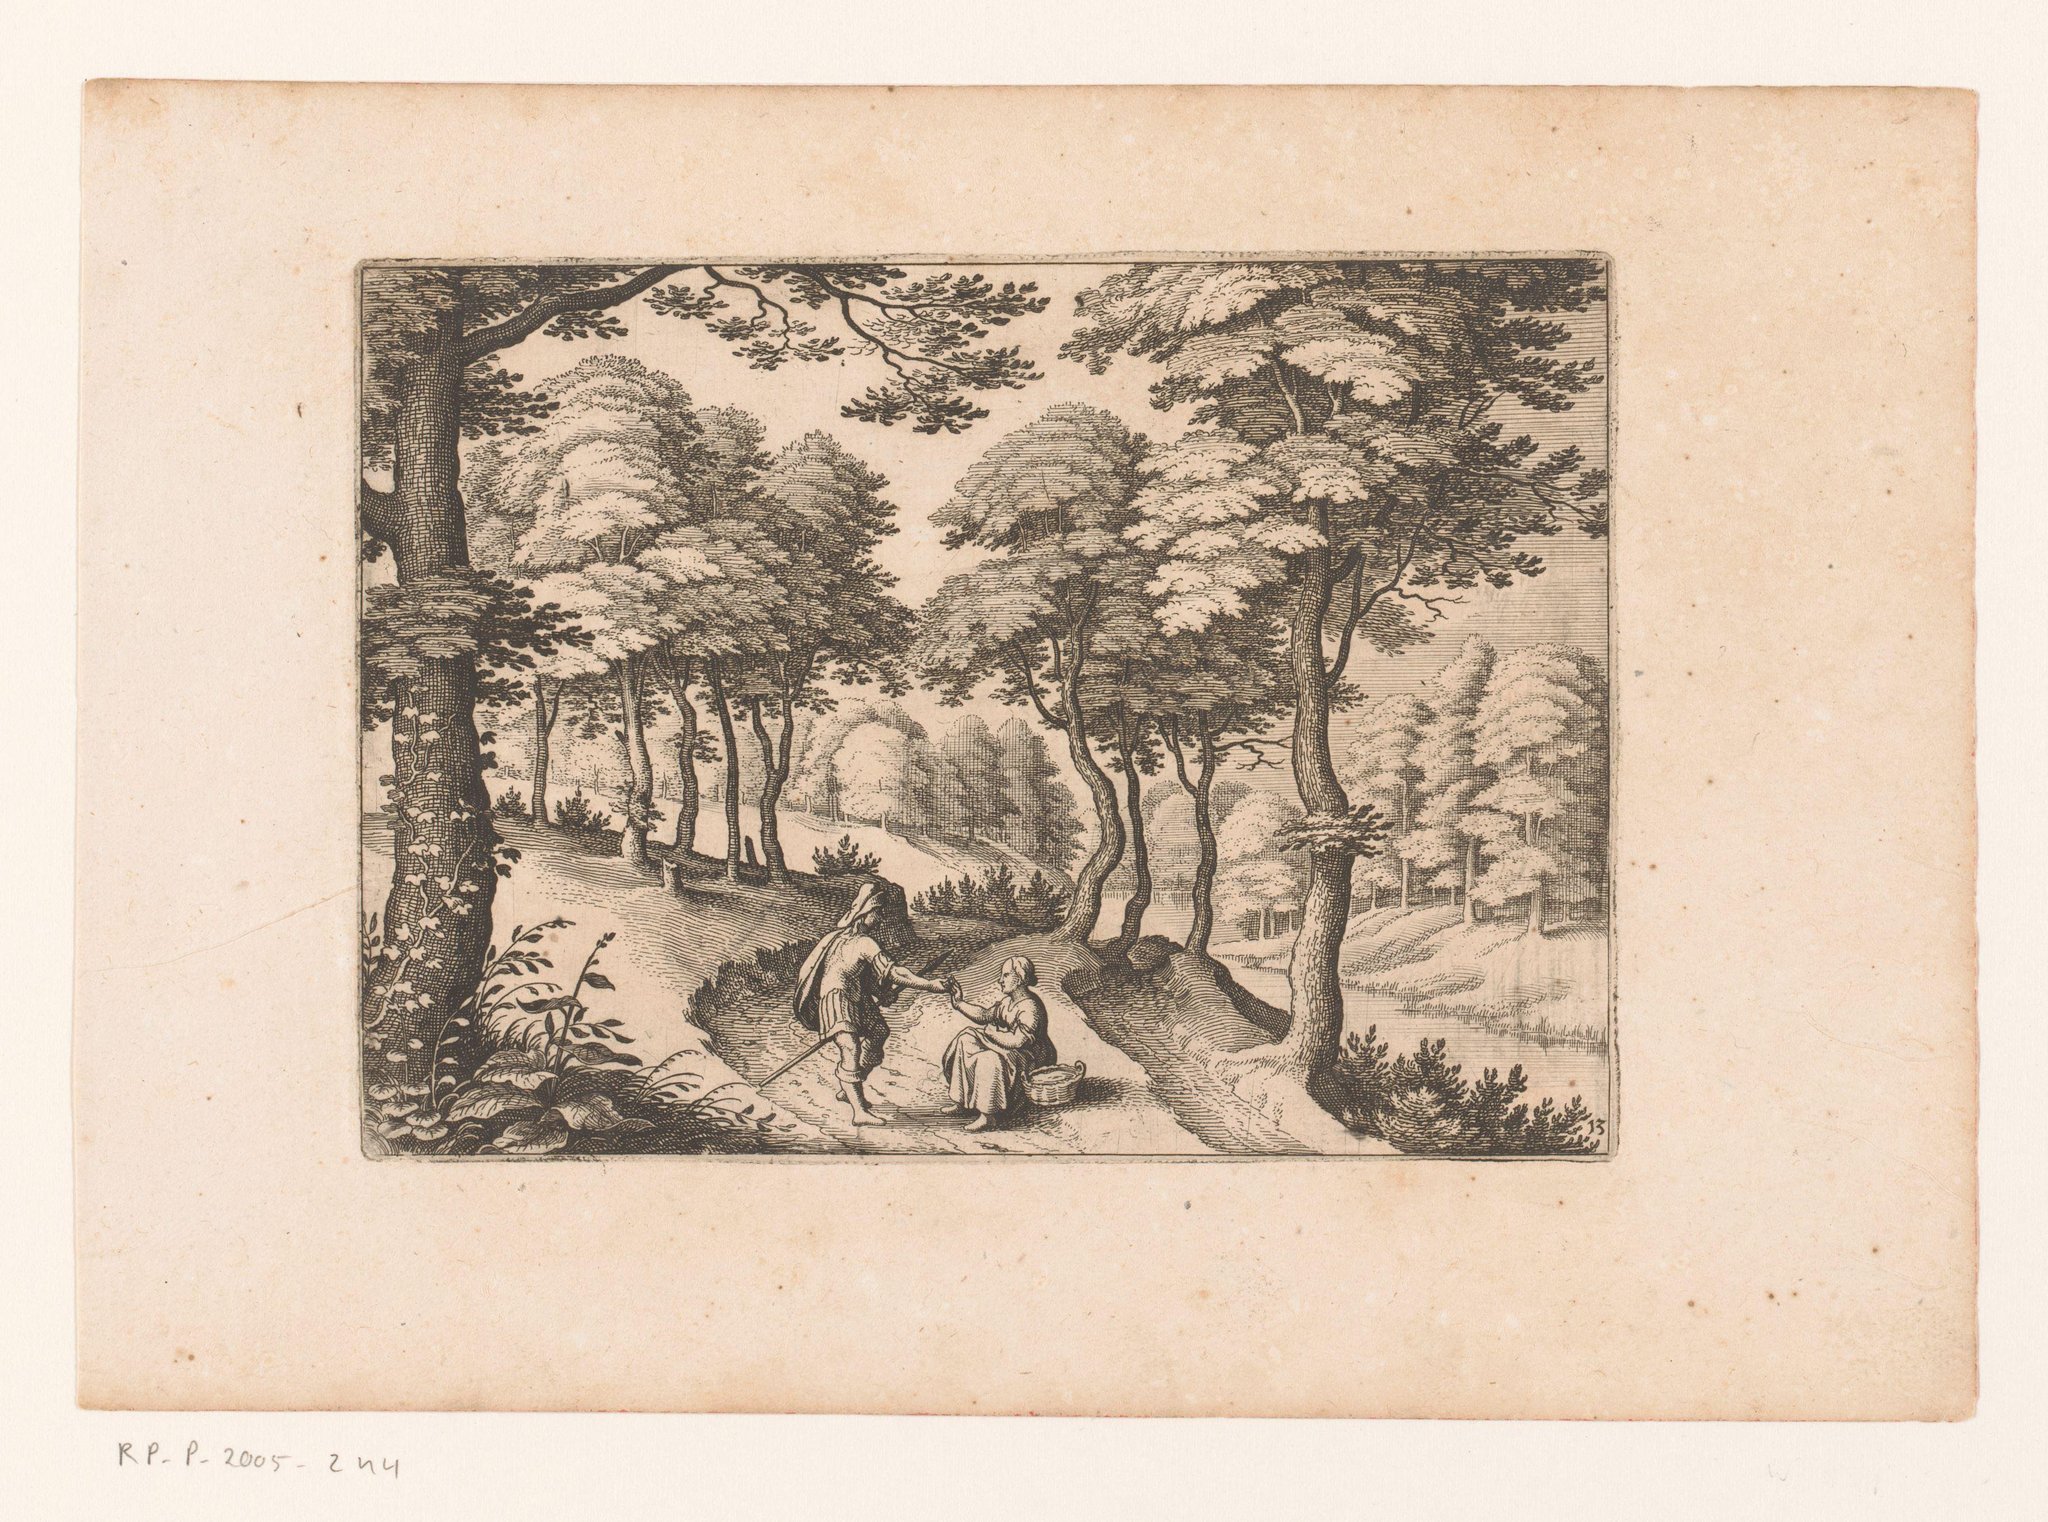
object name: print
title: Landschappen in de Schwalbach-regio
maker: matthäus merian (i)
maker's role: print maker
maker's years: 1593-1650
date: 1620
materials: paper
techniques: etching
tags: judah's love-affair with tamar; he gives her his signet(-ring), bracelets and staff, river, fringe, edge of the wood, road, path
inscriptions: collector's mark: Lugt 2760, collector's mark: Lugt 2228